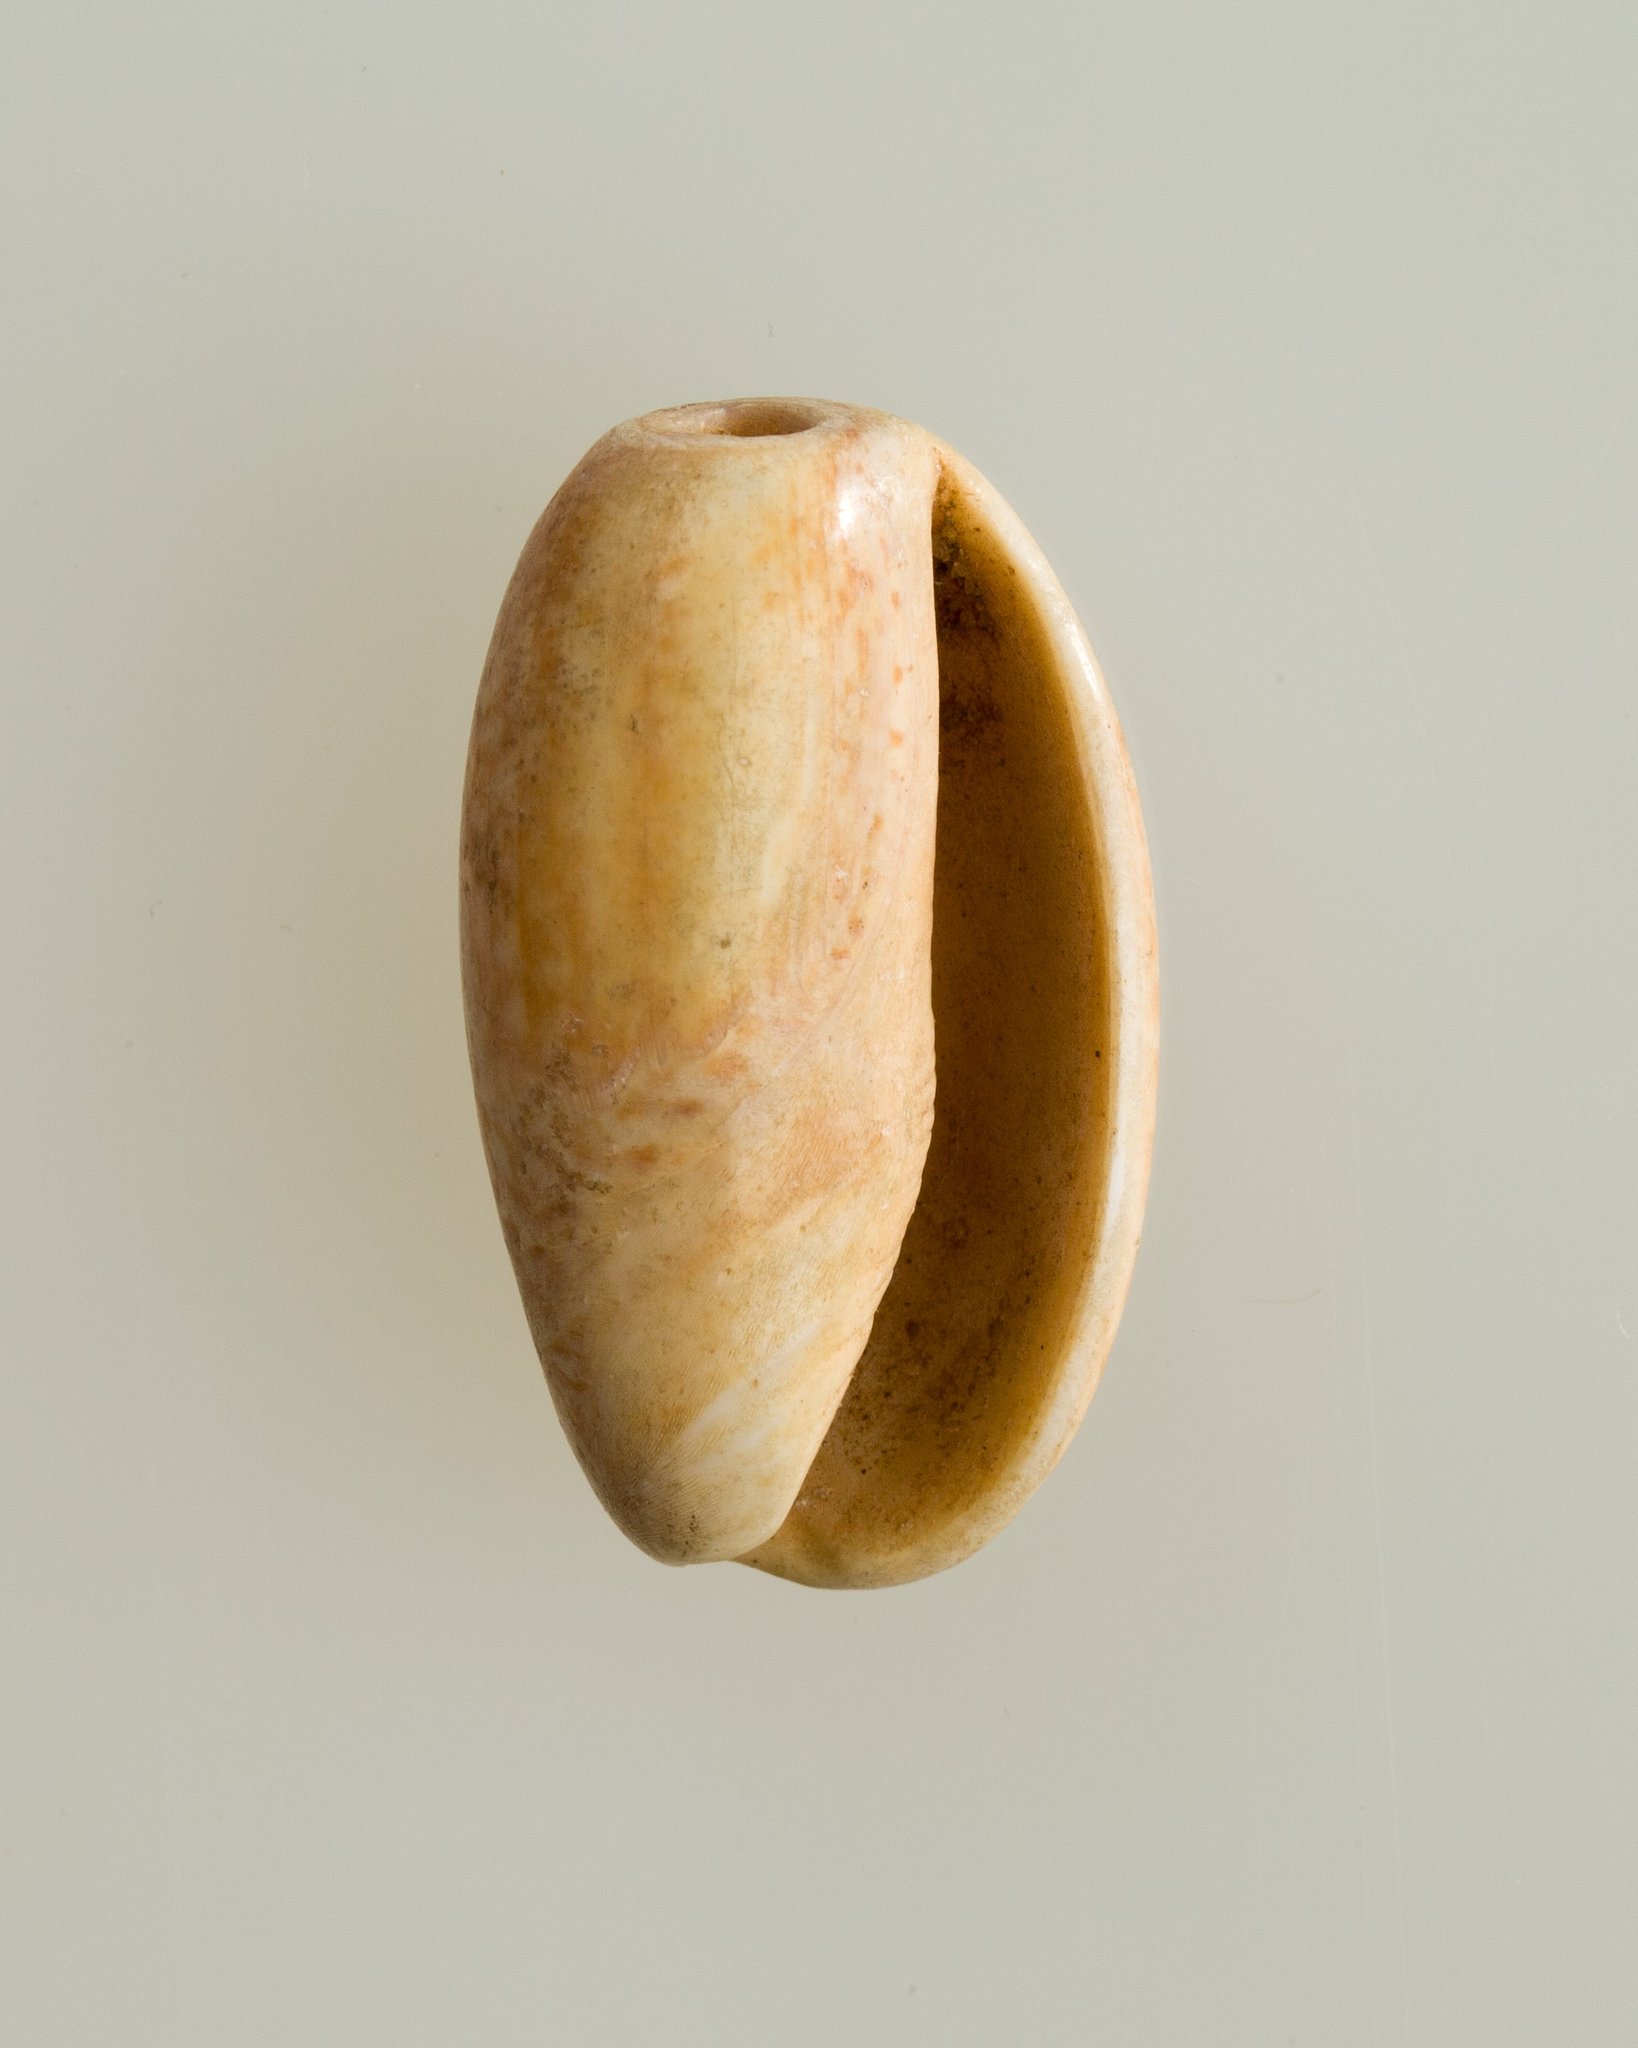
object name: pendant, shell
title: Shell pendant or bead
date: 3850-2960 BCE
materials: shell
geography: egypt